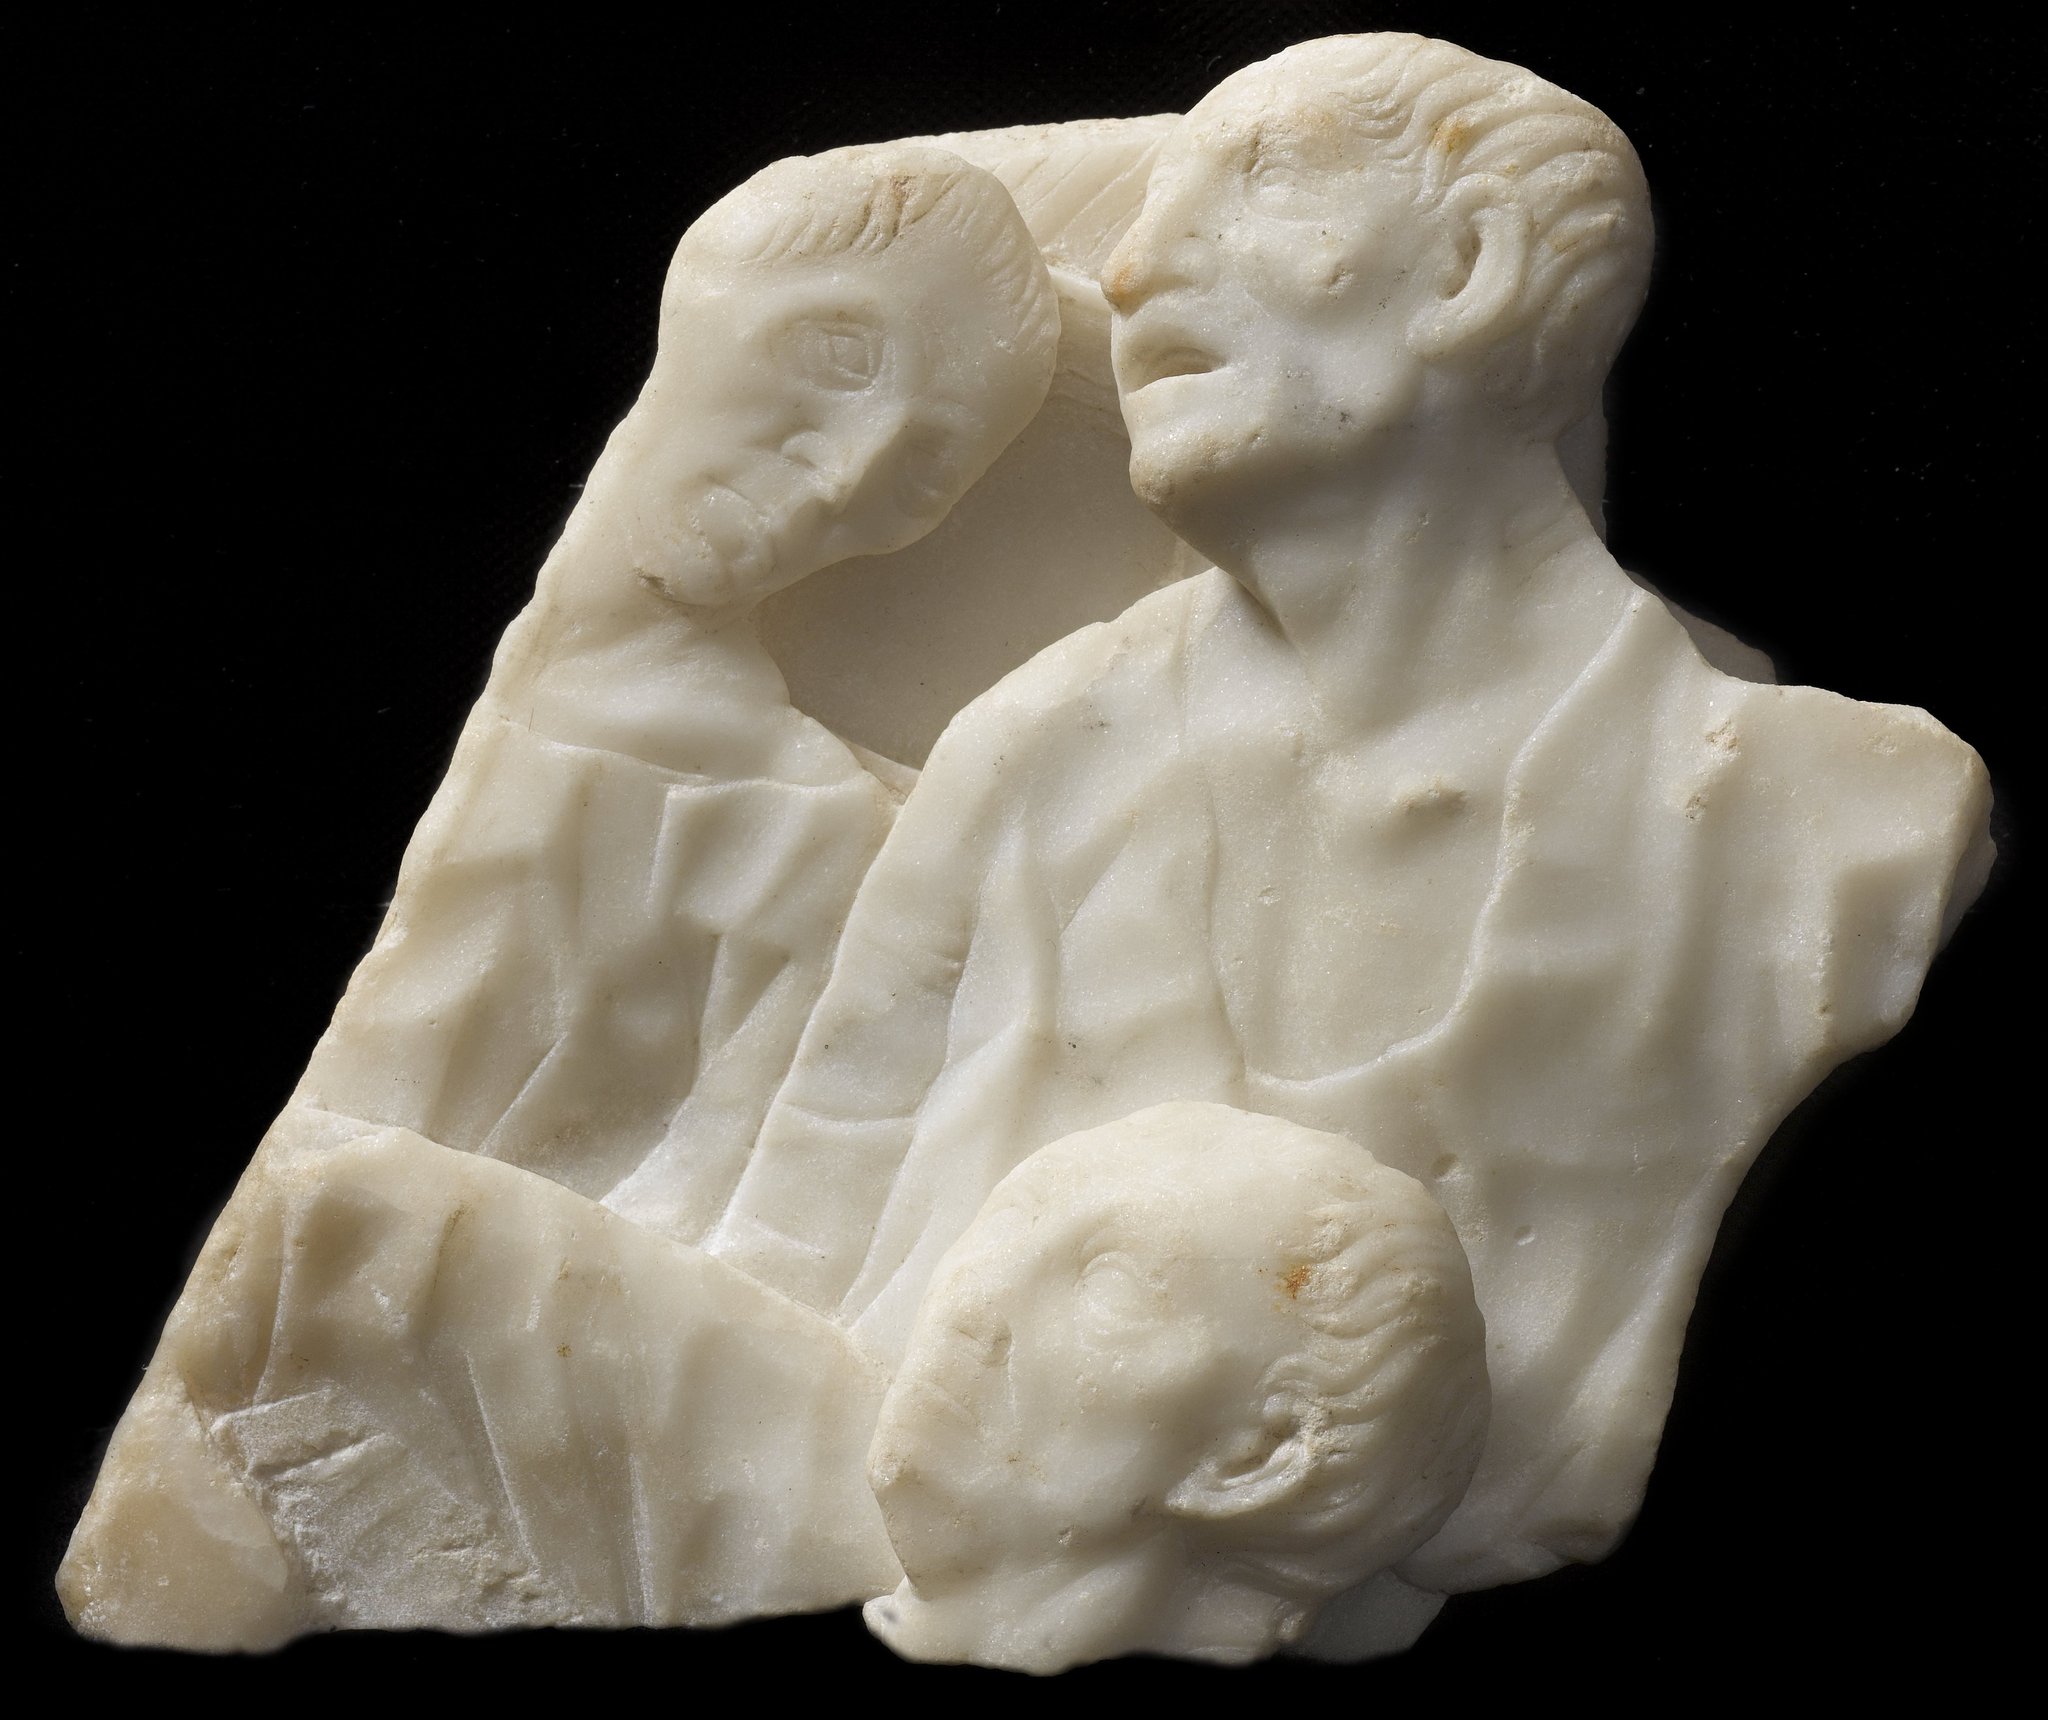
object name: sculpture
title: Drie mannen, fragment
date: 1475-1499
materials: marble